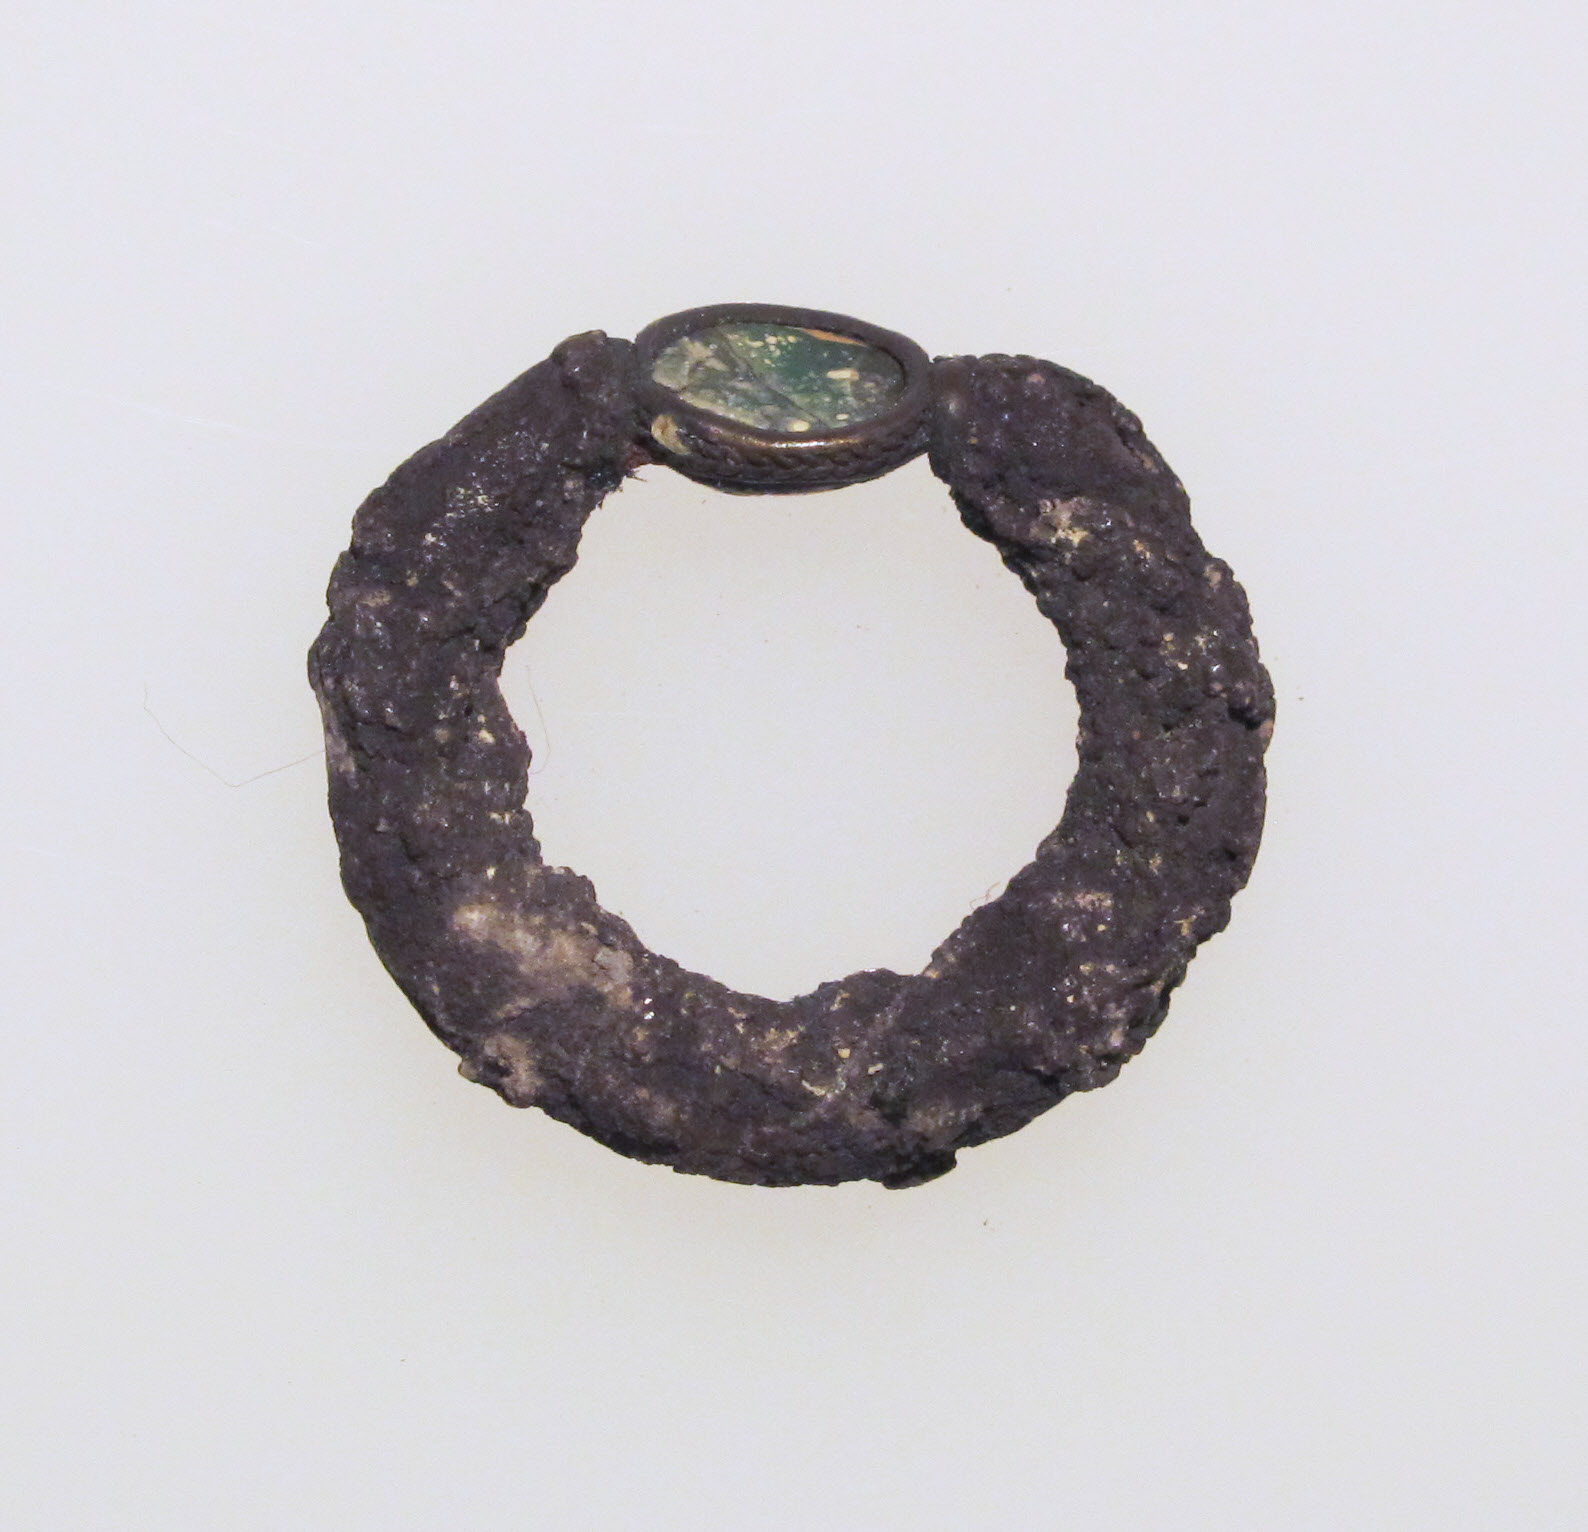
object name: ring with scarab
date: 7000 BCE-330 CE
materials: silver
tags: scarabs